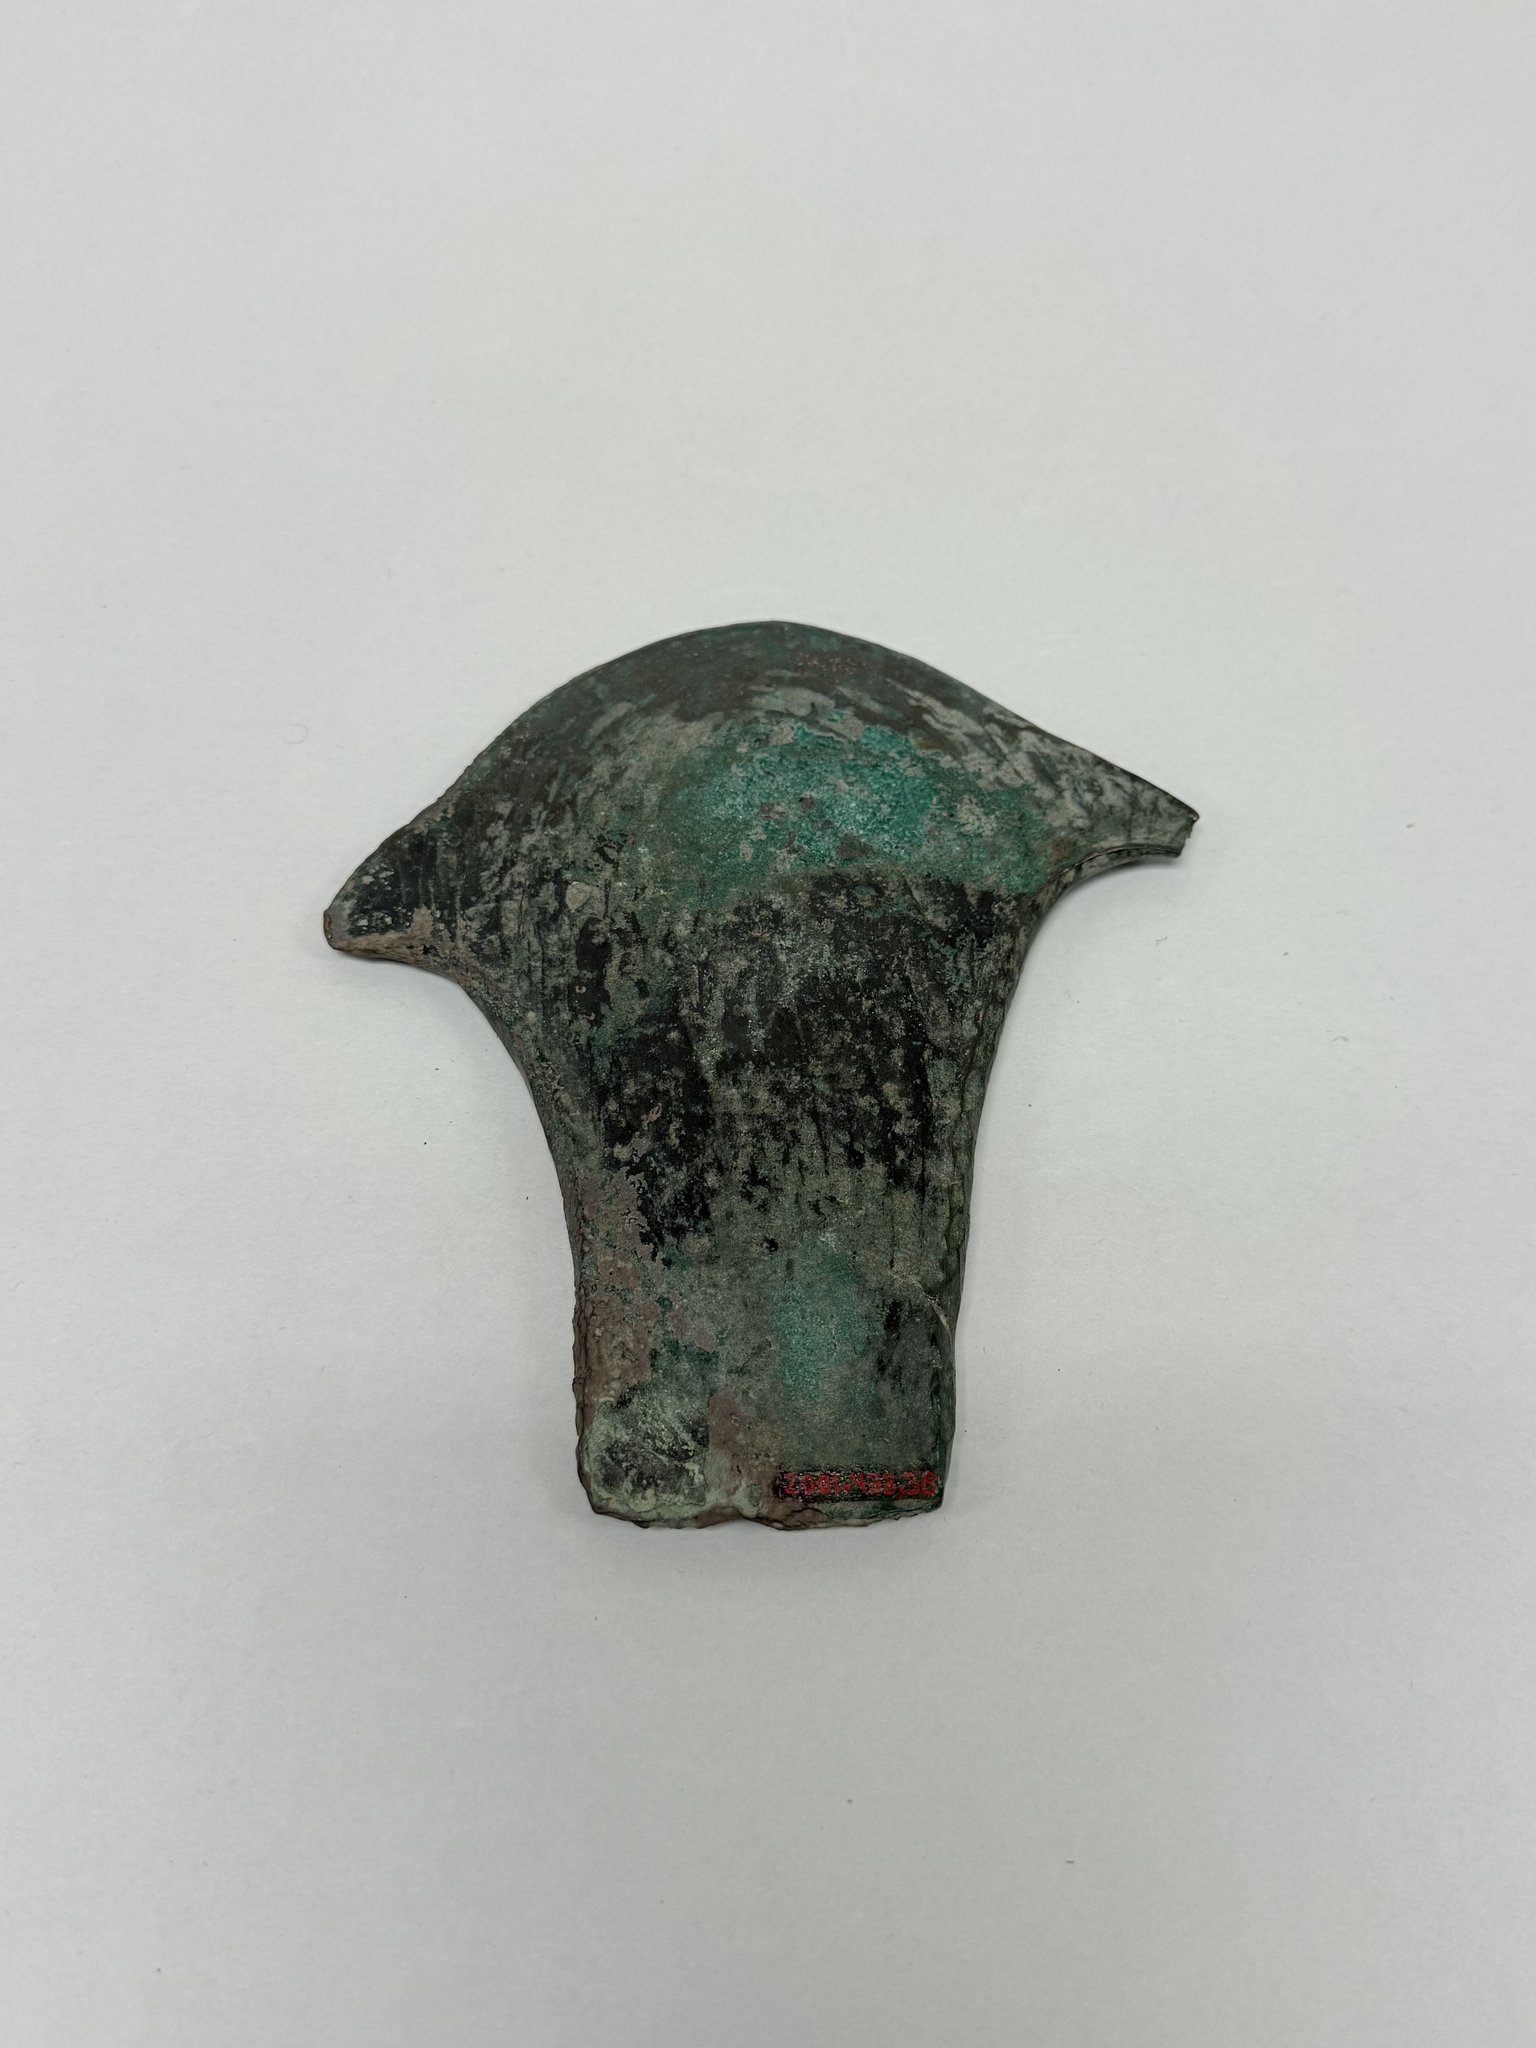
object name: ax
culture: indian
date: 1500-500 BCE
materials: copper